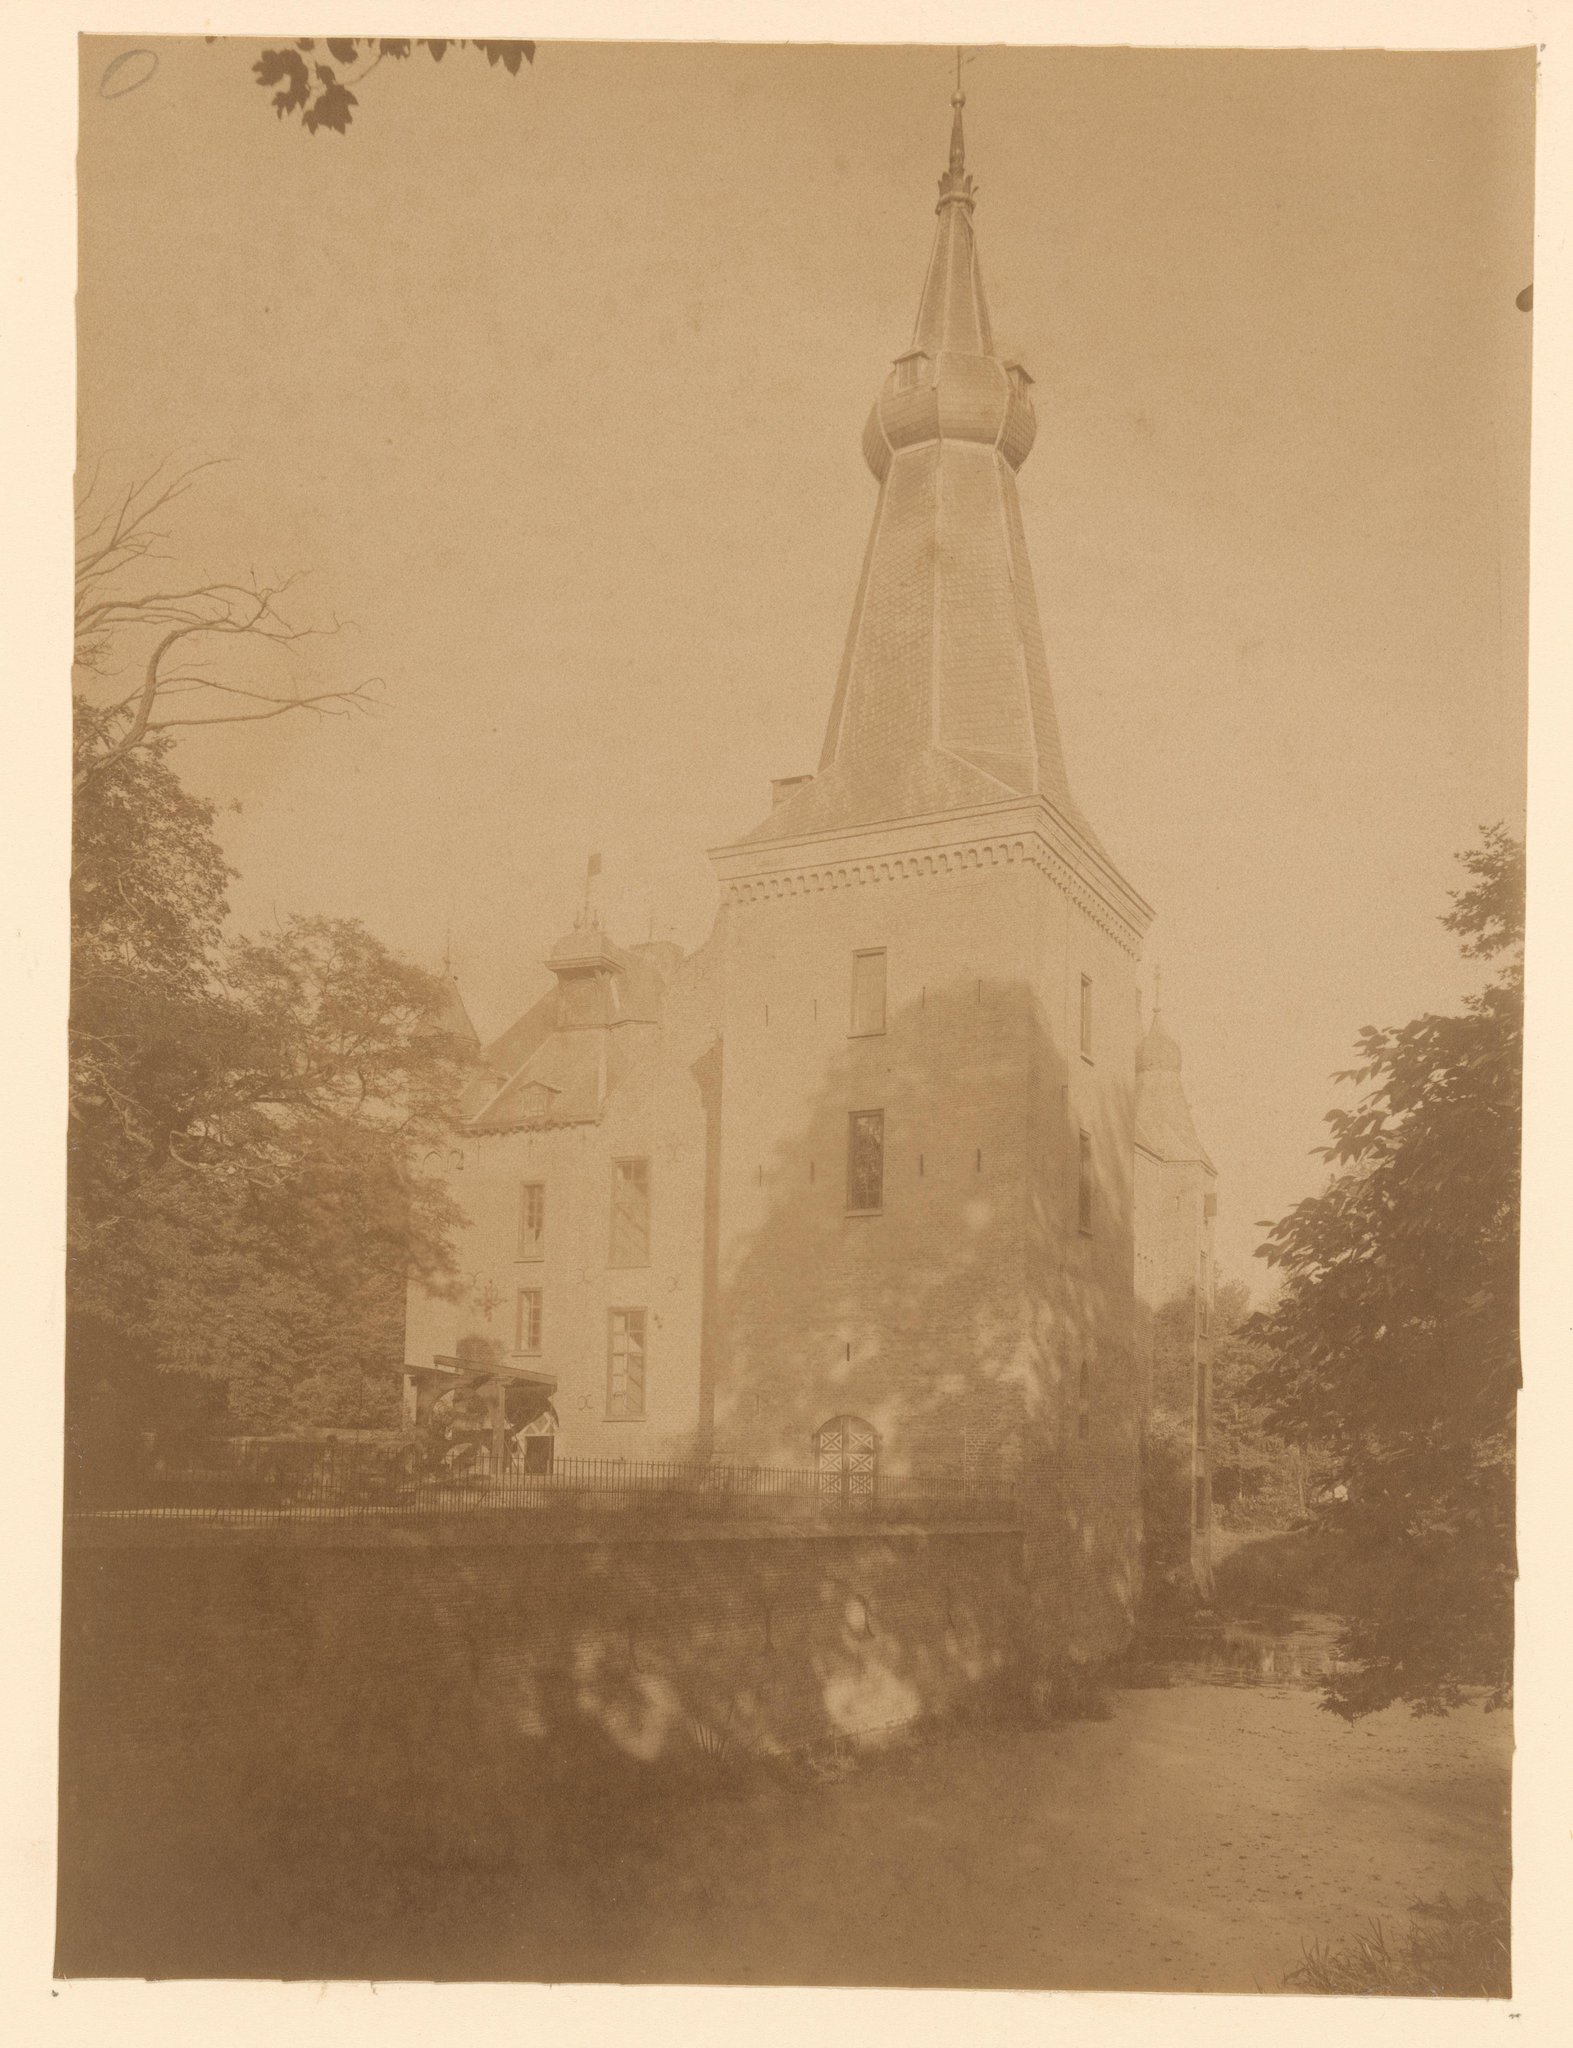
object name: photograph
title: Gezicht op Kasteel Doorwerth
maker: anoniem (monumentenzorg)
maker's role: fotograaf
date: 1890-1920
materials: cardboard, photographic support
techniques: albumen print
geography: kasteel doorwerth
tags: castle, landscape with tower or castle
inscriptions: annotation: ‘O’, annotation: ‘Kasteel te Doorwerth’